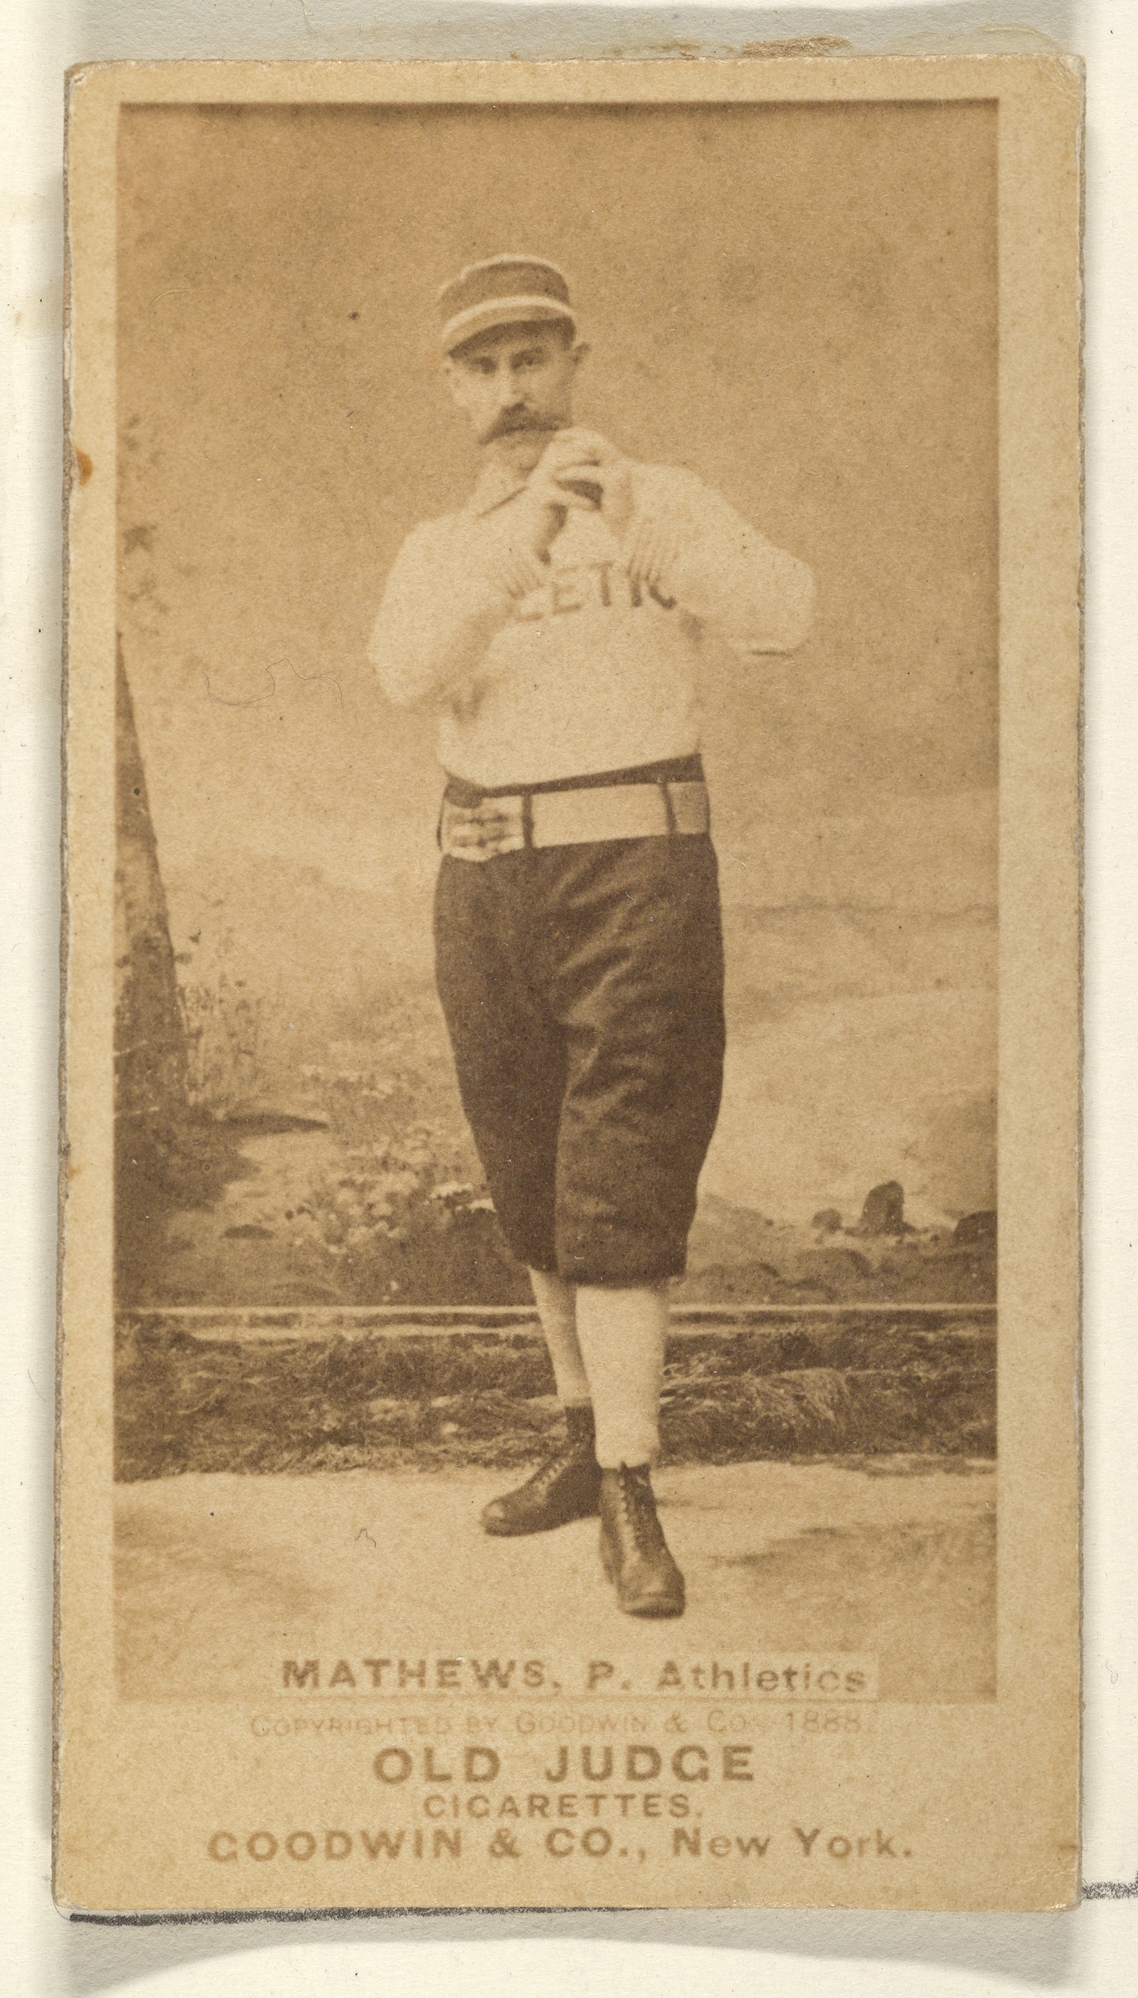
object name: baseball card, photograph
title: Mathews, Pitcher, Philadelphia Athletics, from the Old Judge series (N172) for Old Judge Cigarettes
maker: goodwin & company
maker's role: publisher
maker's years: 1850-1950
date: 1888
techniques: albumen silver print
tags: men,portraits,baseball,athletes